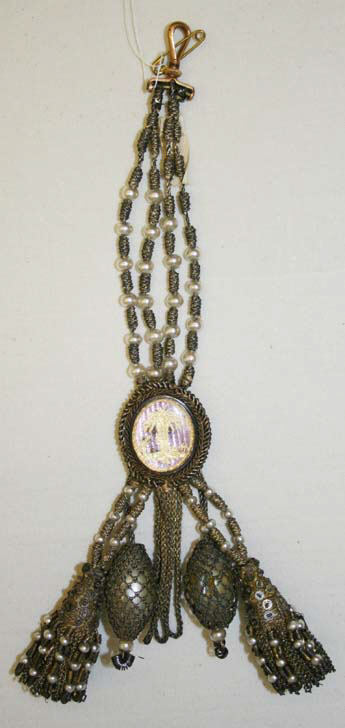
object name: fob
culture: french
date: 1801-1833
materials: metal